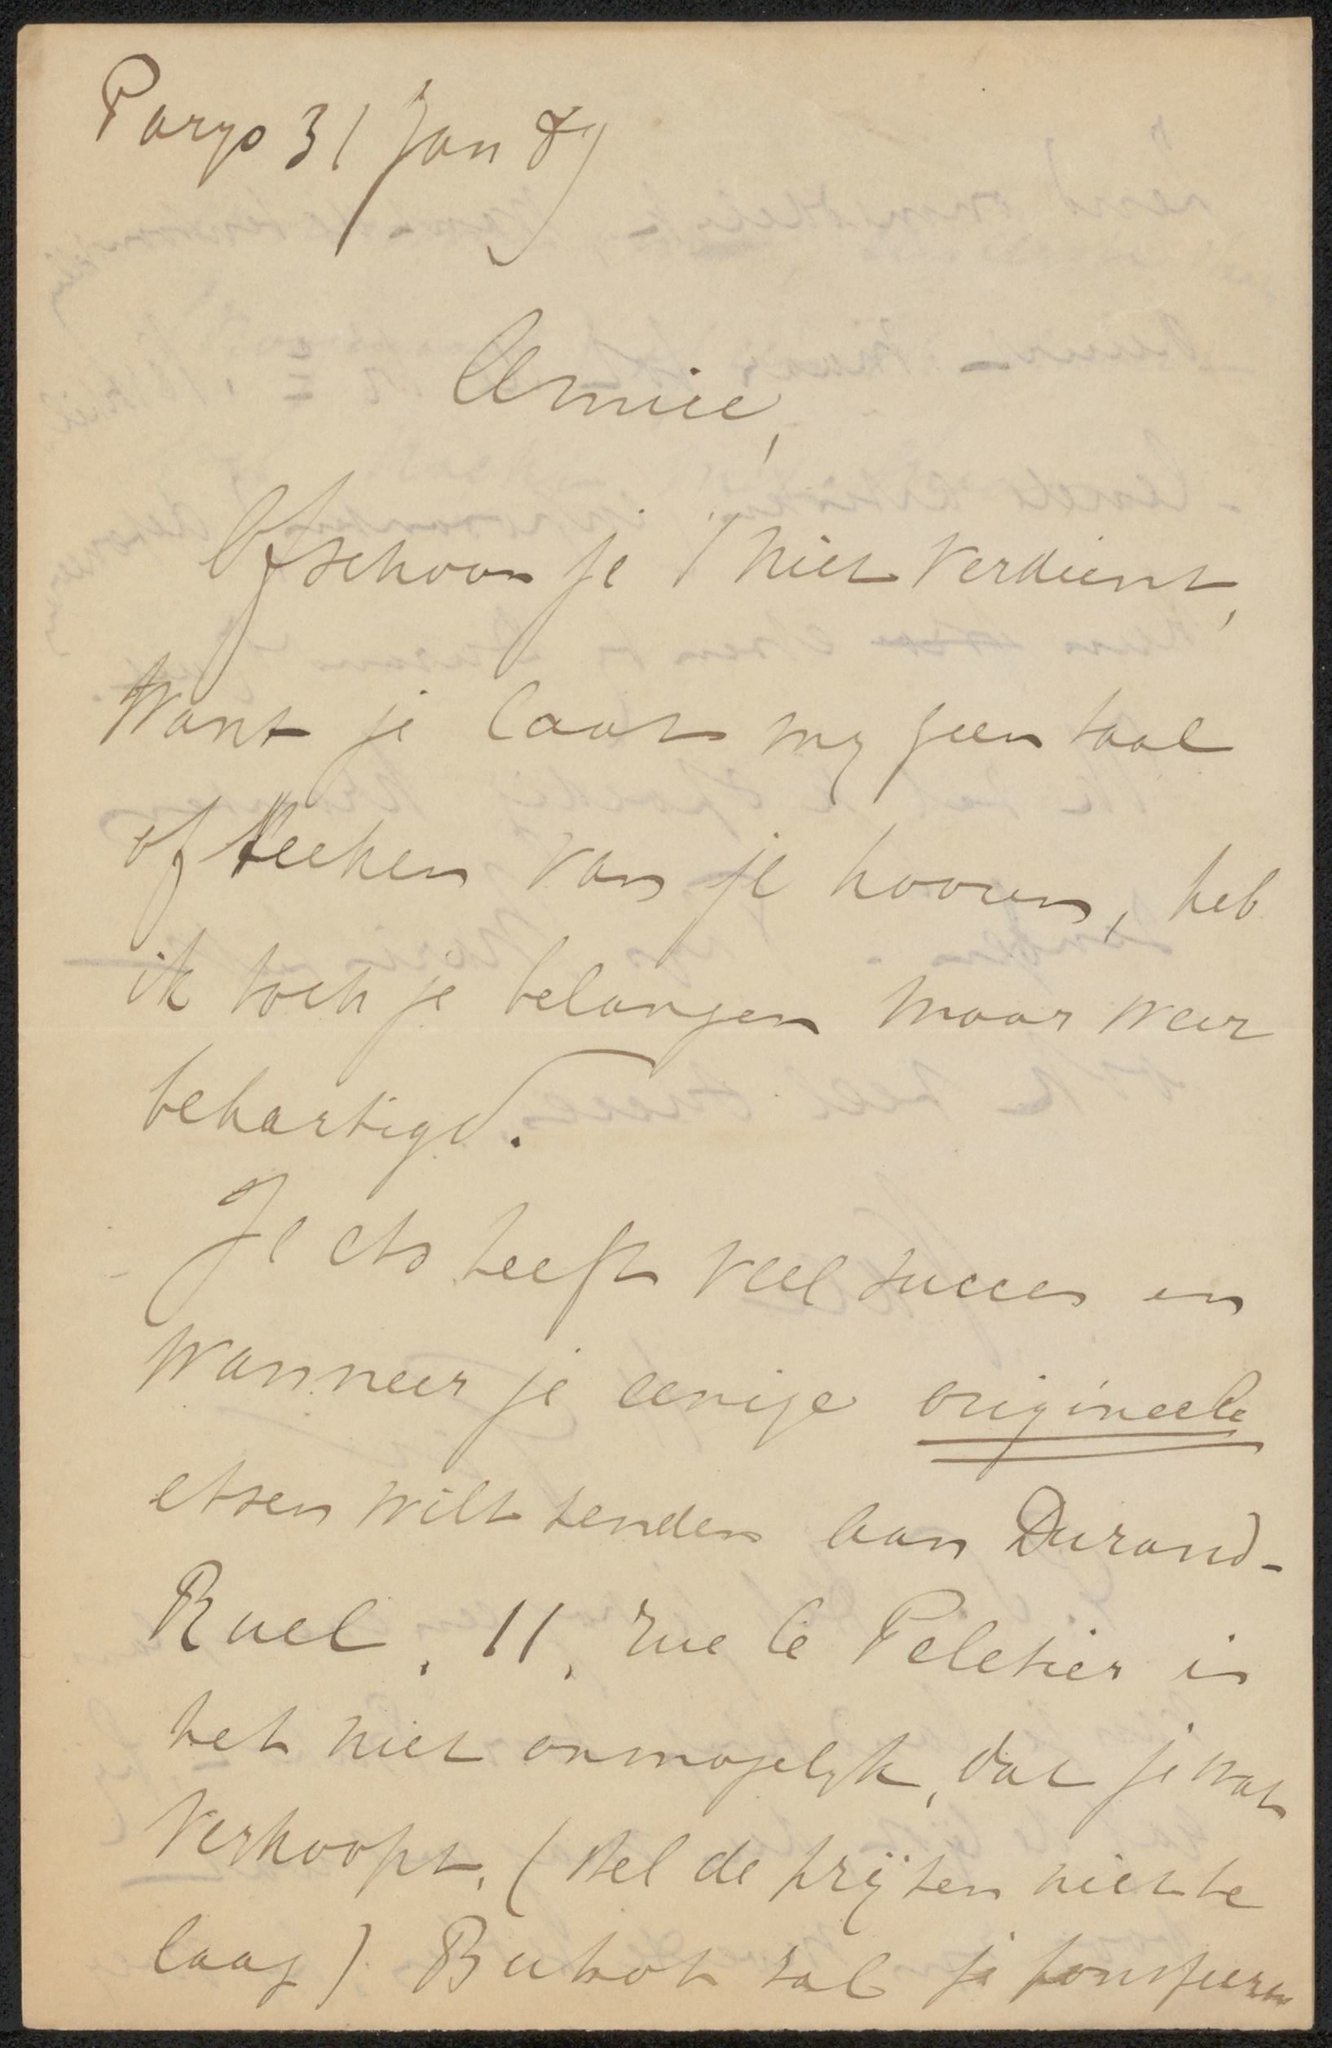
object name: letter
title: Brief aan Philip Zilcken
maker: adriaan pit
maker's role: print maker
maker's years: 1860-1944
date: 1889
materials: ink, paper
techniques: pen, writing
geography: paris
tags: the hague, london, painter, print maker, draughtsman, matthijs maris, félix hilaire buhot, paul durand-ruel, philip zilcken, the graphic arts, exhibition ~ art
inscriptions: collector's mark: ‘RPK’